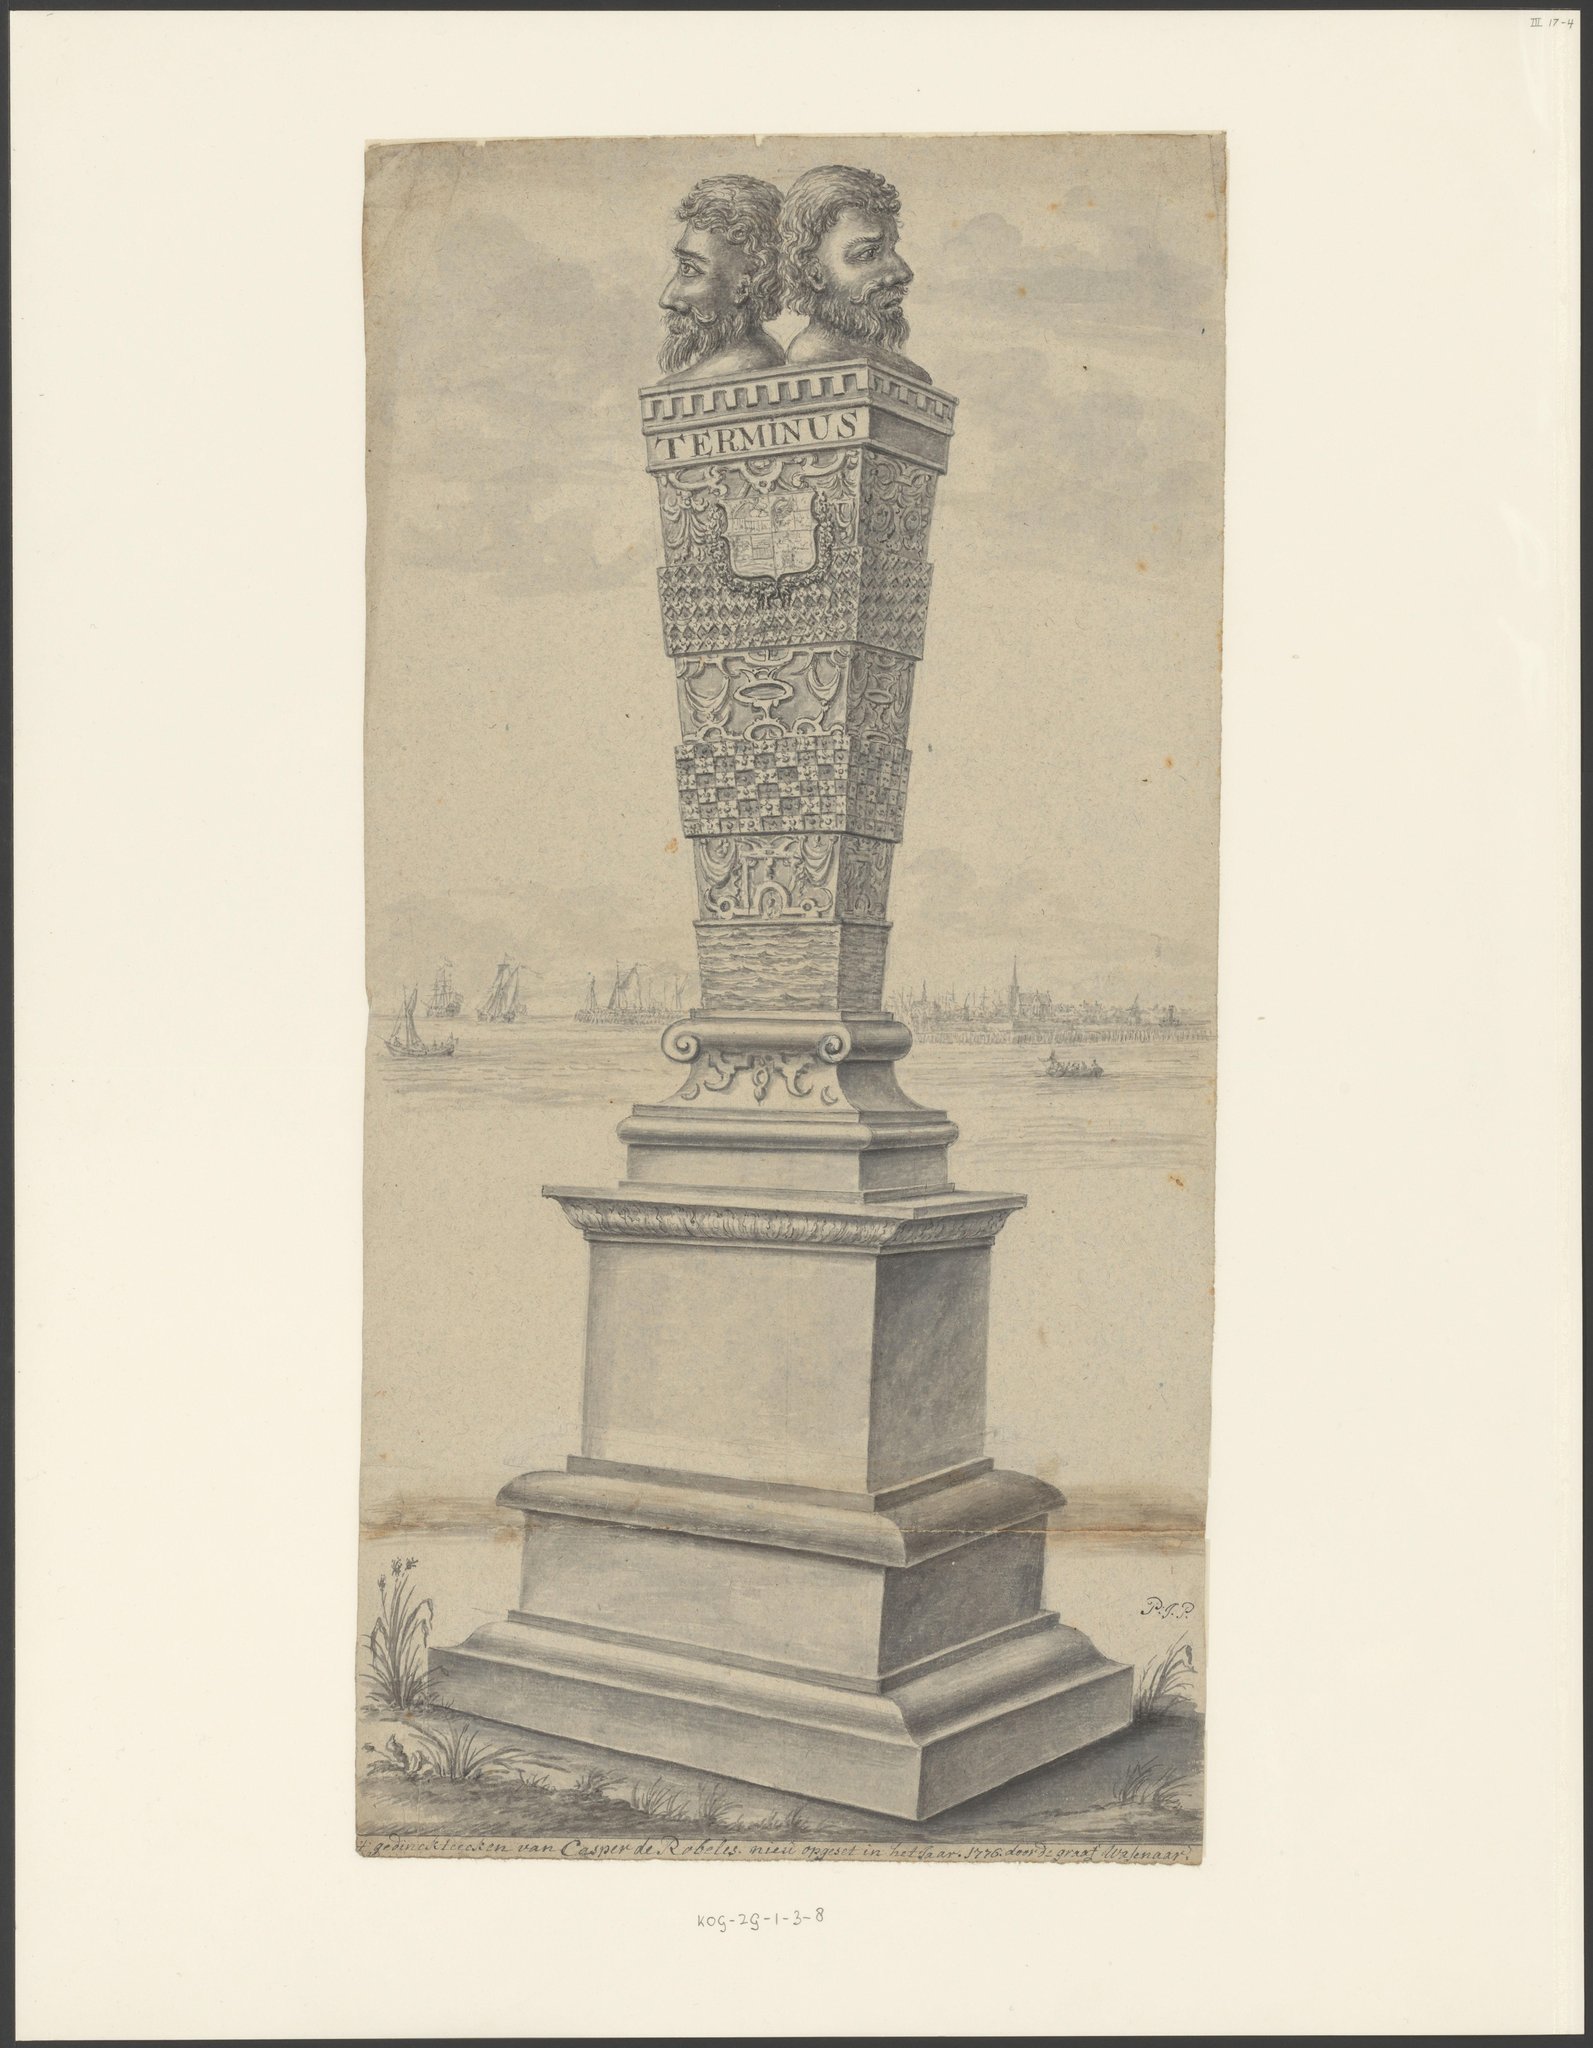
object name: drawing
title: Gedenkteken de Stenen Man ter herdenking van het herstel van de dijken in Harlingen na de Allerheiligenvloed, 1570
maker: Anonymous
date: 1776-1849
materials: ink, paper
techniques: brush, pen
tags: antwerp, caspar de robles, dikes, levee, monument, statue, janus' head, two-faced head, harlingen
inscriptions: signature: ‘PIP’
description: Gedenkteken de stenen man ter herdenking van het herstel van de dijken in Harlingen na de Allerheiligenvloed, 1570. Op het standbeeld staan de twee koppen van de Romeinse God Janus. Onderwerpsrubrieken binnen de Atlas Zeden en Gewoonten: Regeering, Dijkdoorbraken en waternoden.